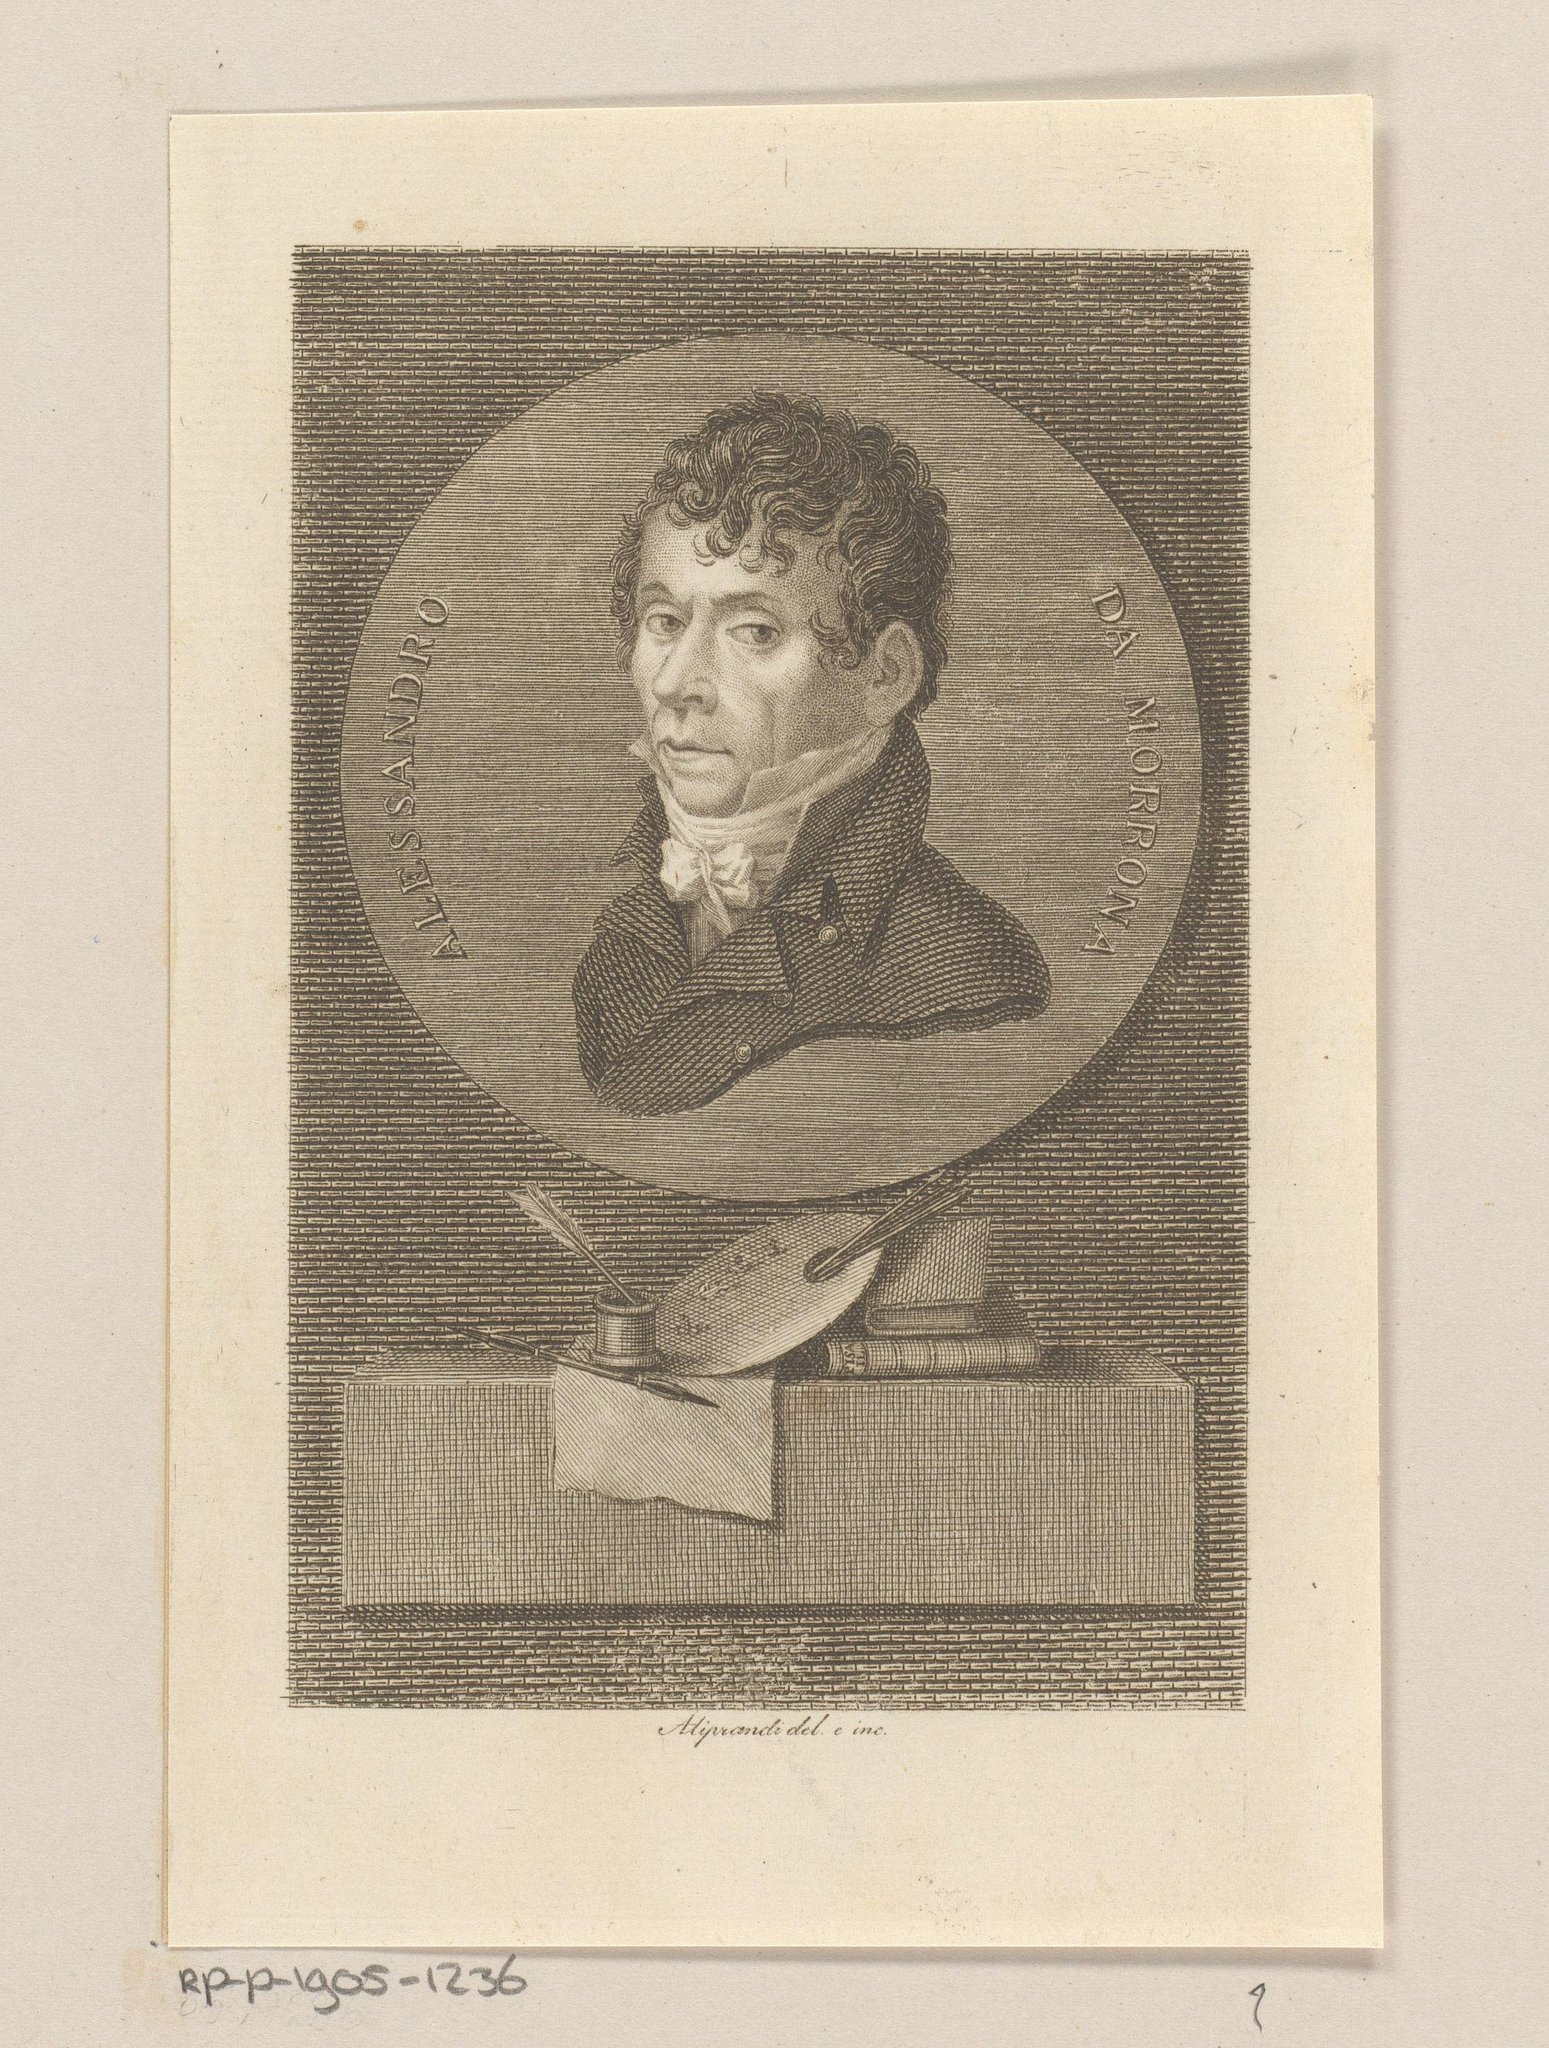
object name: print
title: Portret van Alessandro da Morrona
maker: giacomo aliprandi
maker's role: draughtsman, print maker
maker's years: 1775-1855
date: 1812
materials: paper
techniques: engraving, etching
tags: painter, historical persons, portrait of a writer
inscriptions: collector's mark: Lugt 2228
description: Prent waarschijnlijk uit: Morrona, Alessandro da. Pisa illustrata nelle arti del disegno. Livorno: Presso Giovanni Marenigh, 1812.